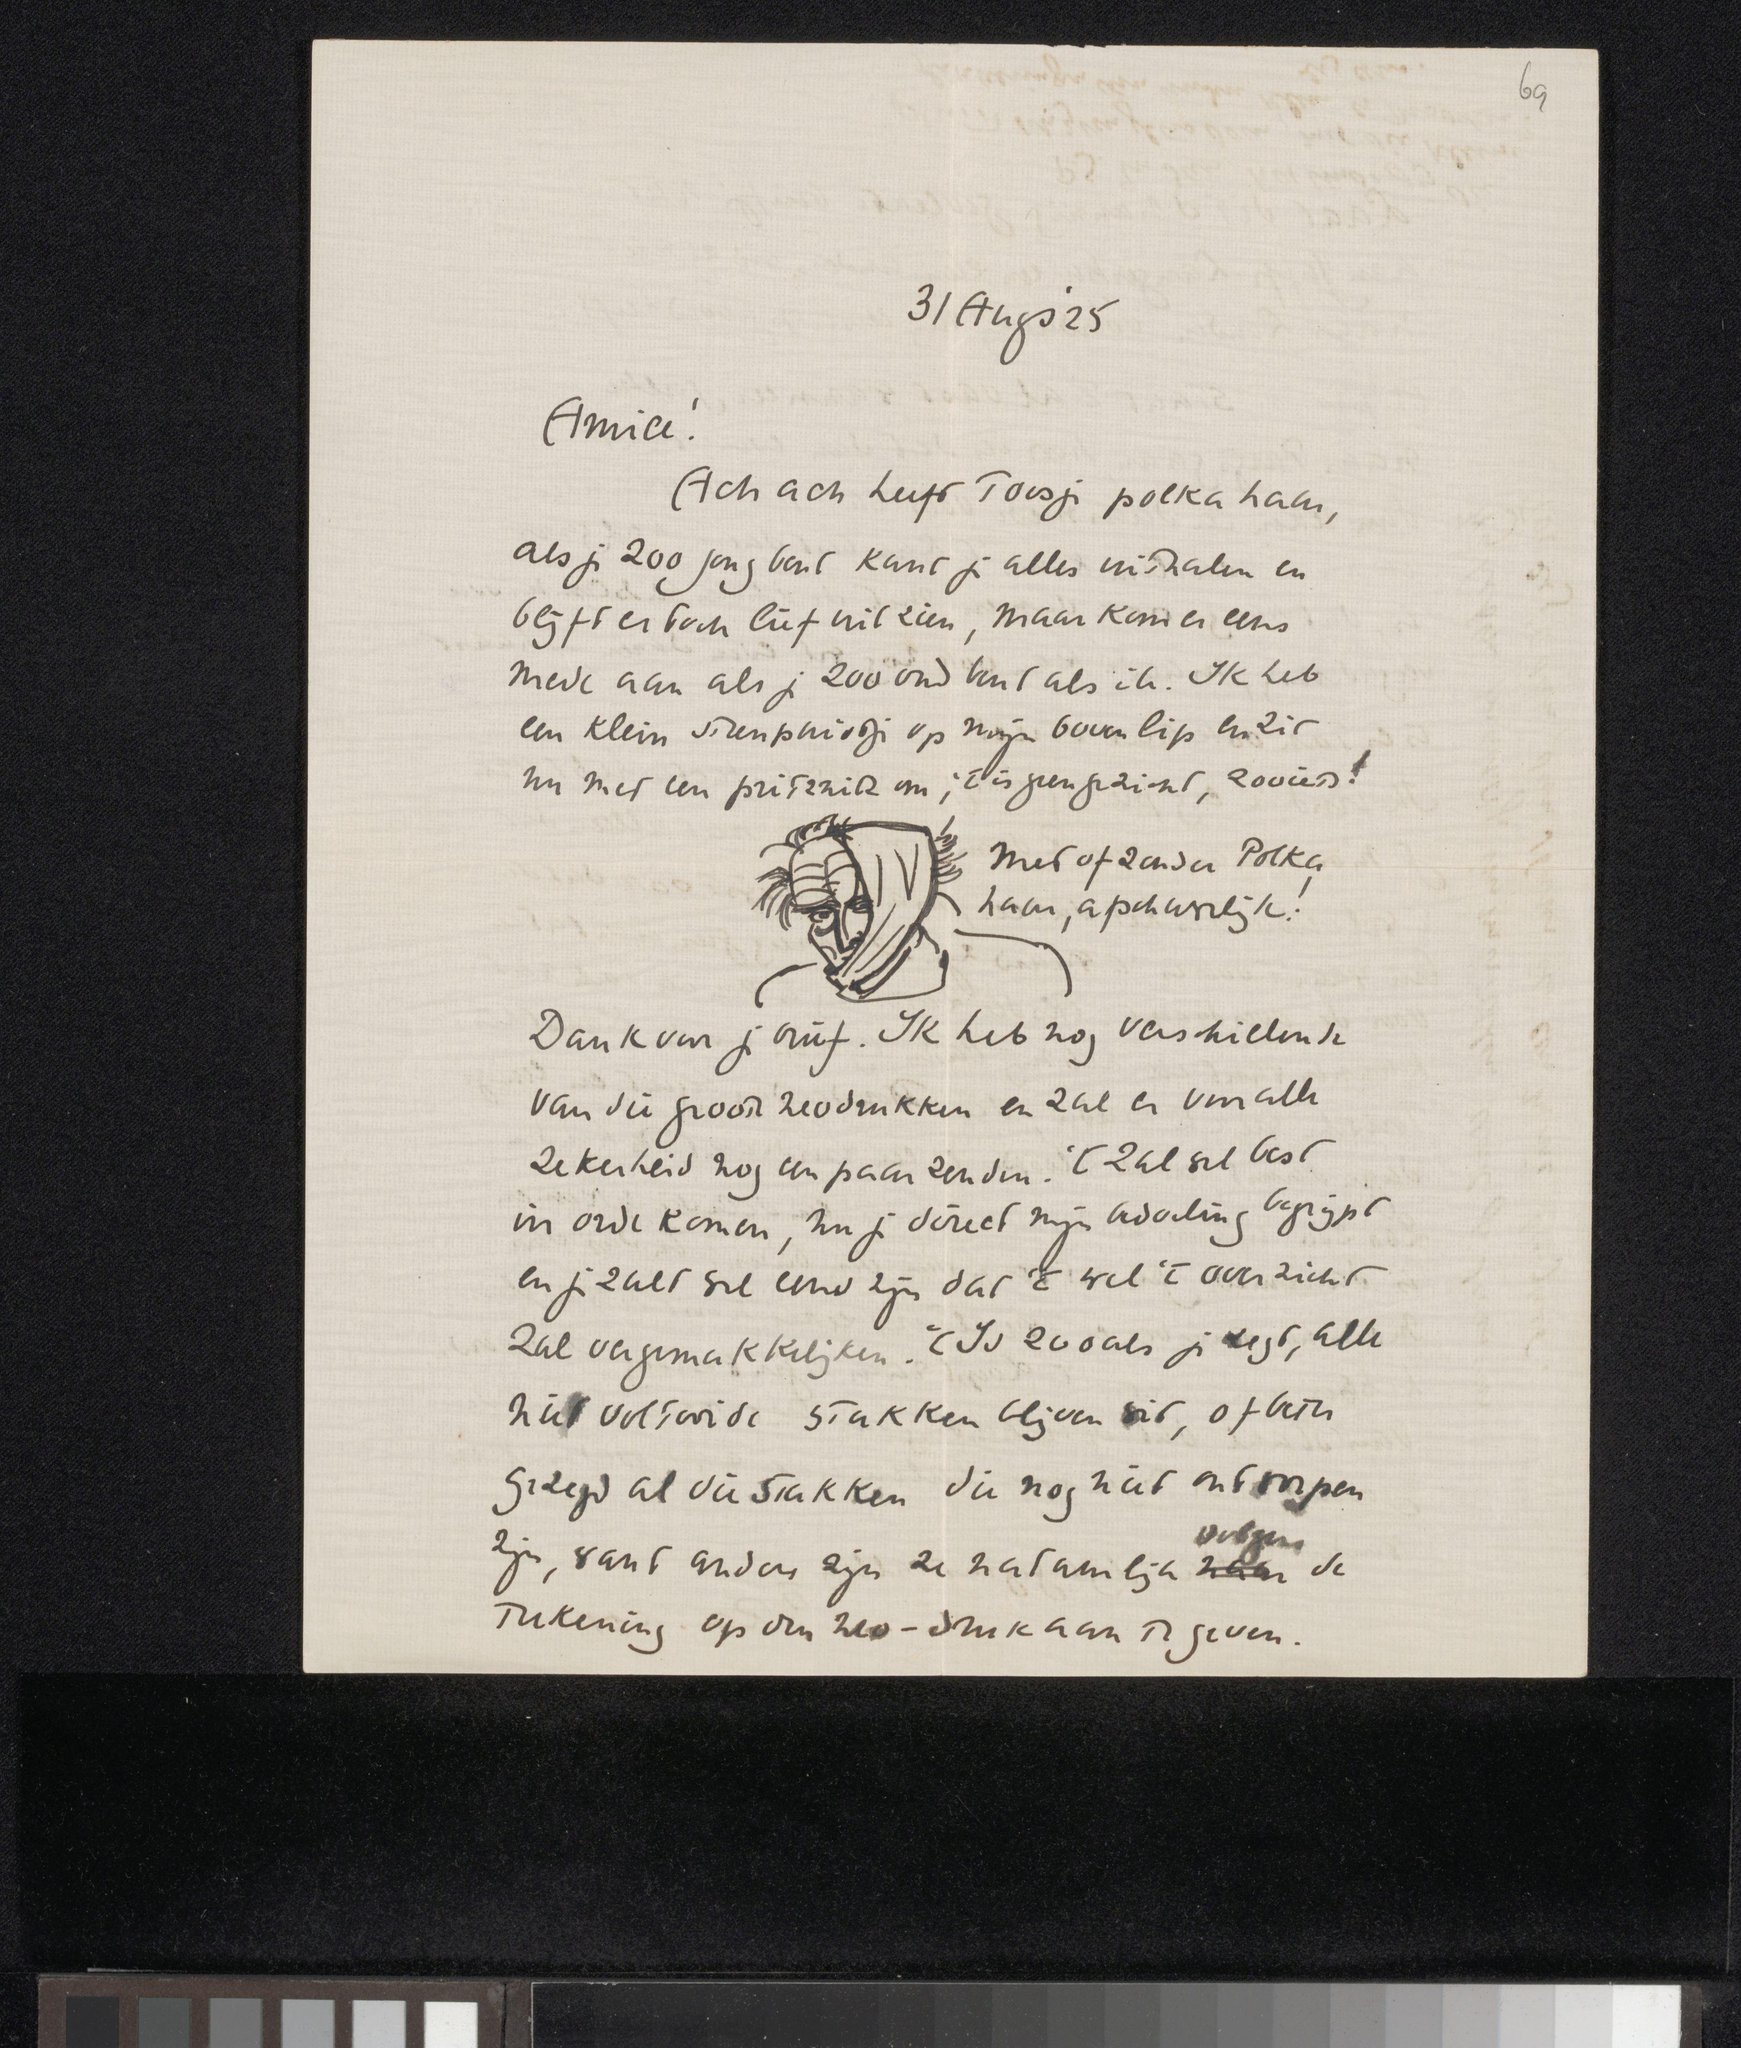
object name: letter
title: Brief aan Willem Bogtman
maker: richard nicolaüs roland holst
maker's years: 1868-1938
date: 1925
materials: ink, paper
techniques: pen, writing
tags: willem bogtman, amsterdam, designer, jan frederik staal, piet l. kramer, head (human), drawing, applied arts, arts and crafts; industrial design, diseases, haarlem, london, rotterdam, paris